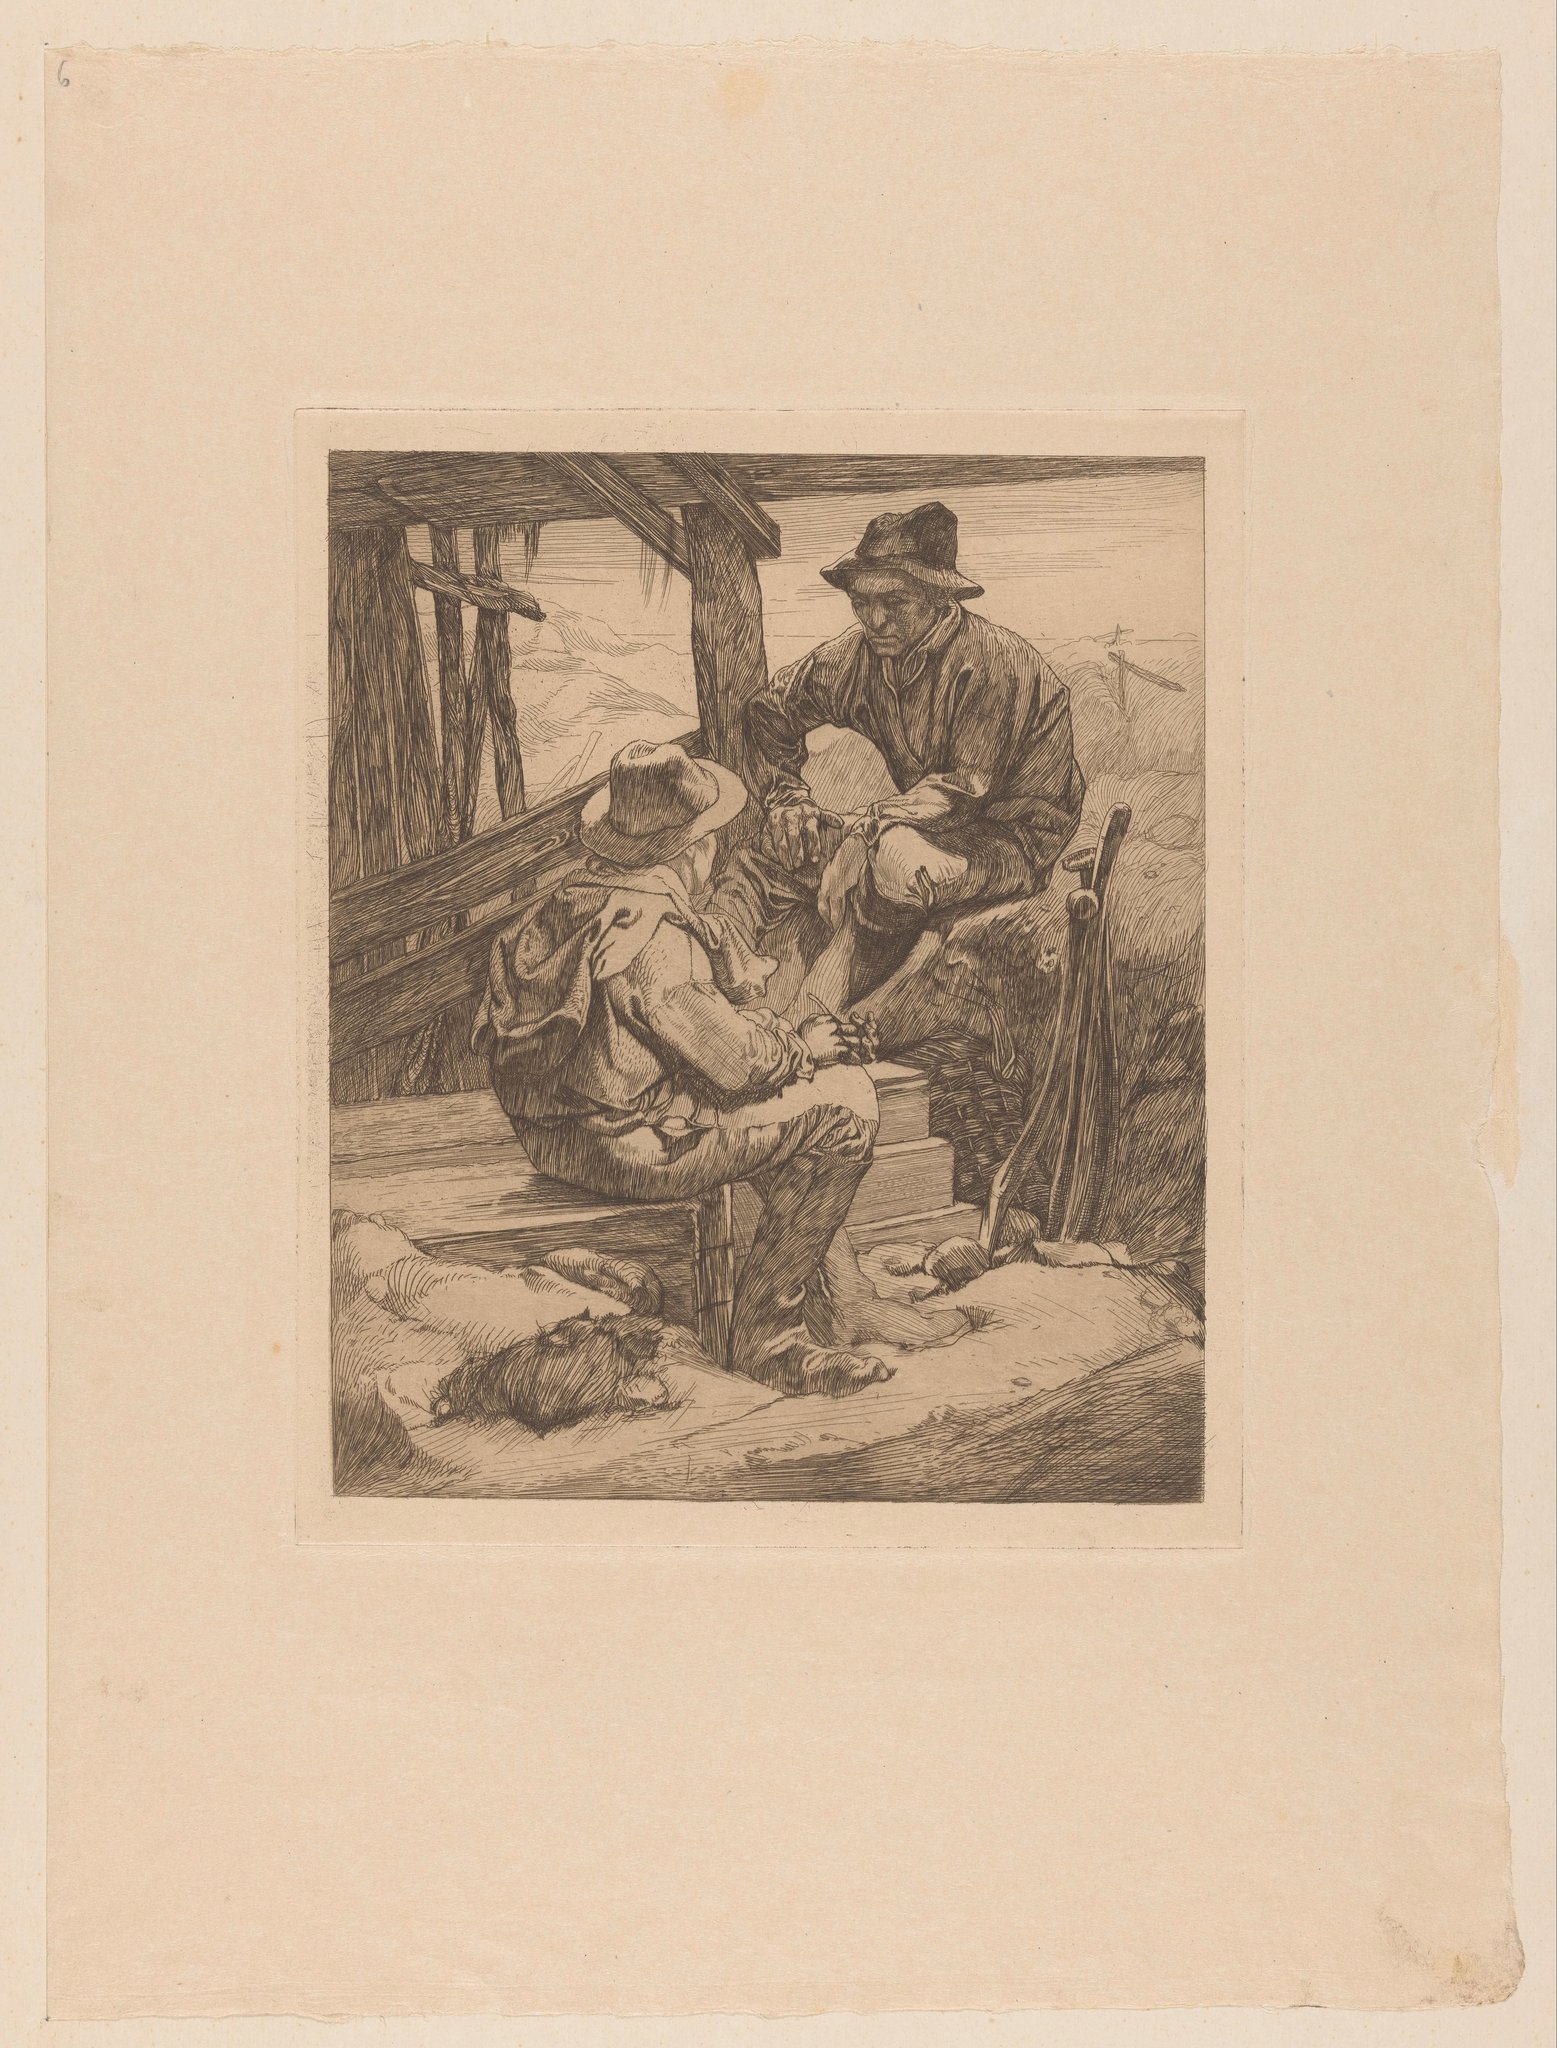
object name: print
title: Twee rustende arbeiders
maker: johannes josephus aarts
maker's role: draughtsman, print maker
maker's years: 1871-1934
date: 1881-1934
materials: paper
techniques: etching, intaglio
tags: working class, labourers, resting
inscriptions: collector's mark: Lugt 2228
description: Twee mannen in werkkleding met hoed, beiden zittend onder een houten afdak. De man links heeft een pijp in zijn hand.